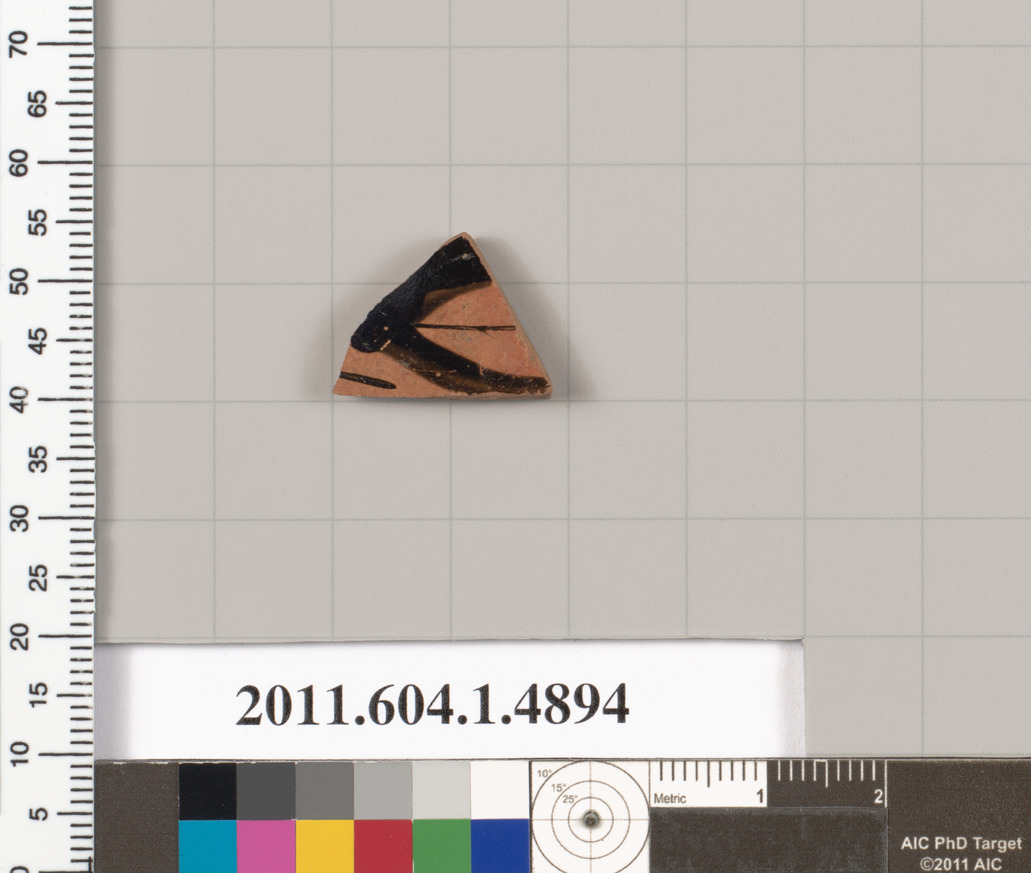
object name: kylix fragment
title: Terracotta fragment of a kylix (drinking cup)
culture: greek, attic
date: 467-435 BCE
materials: terracotta